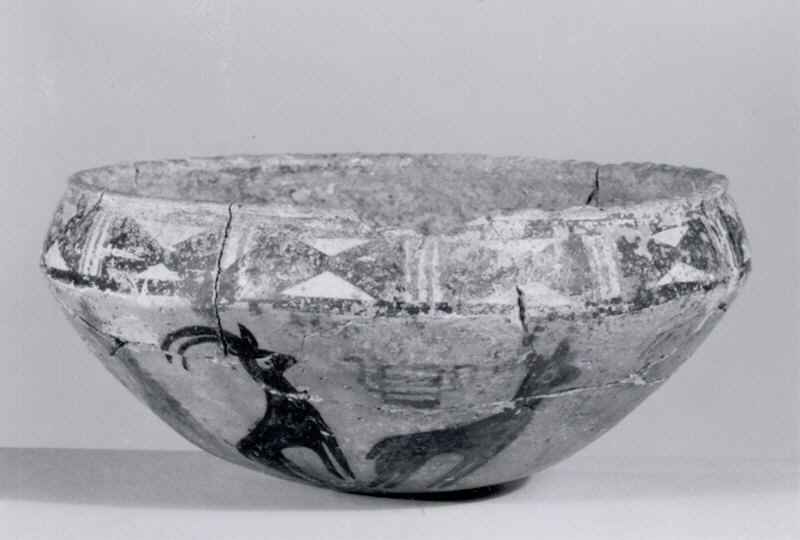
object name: bowl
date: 1900-1450 BCE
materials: ceramic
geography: northwestern iran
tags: animals